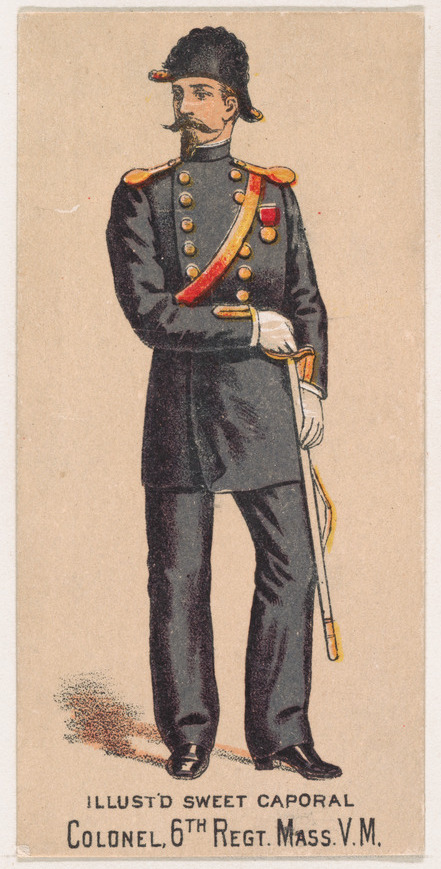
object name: print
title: Colonel, 6th Regiment, Massachusetts, V.M., from the Military Series (N224) issued by Kinney Tobacco Company to promote Sweet Caporal Cigarettes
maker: kinney brothers tobacco company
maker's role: publisher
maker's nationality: american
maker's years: 1869-2011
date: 1888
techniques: color lithograph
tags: military,men